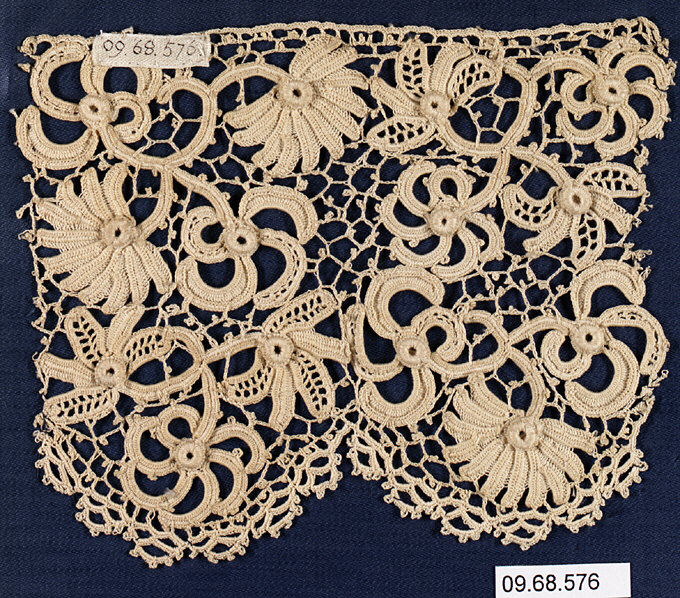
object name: specimen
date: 1801-1900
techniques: crochet